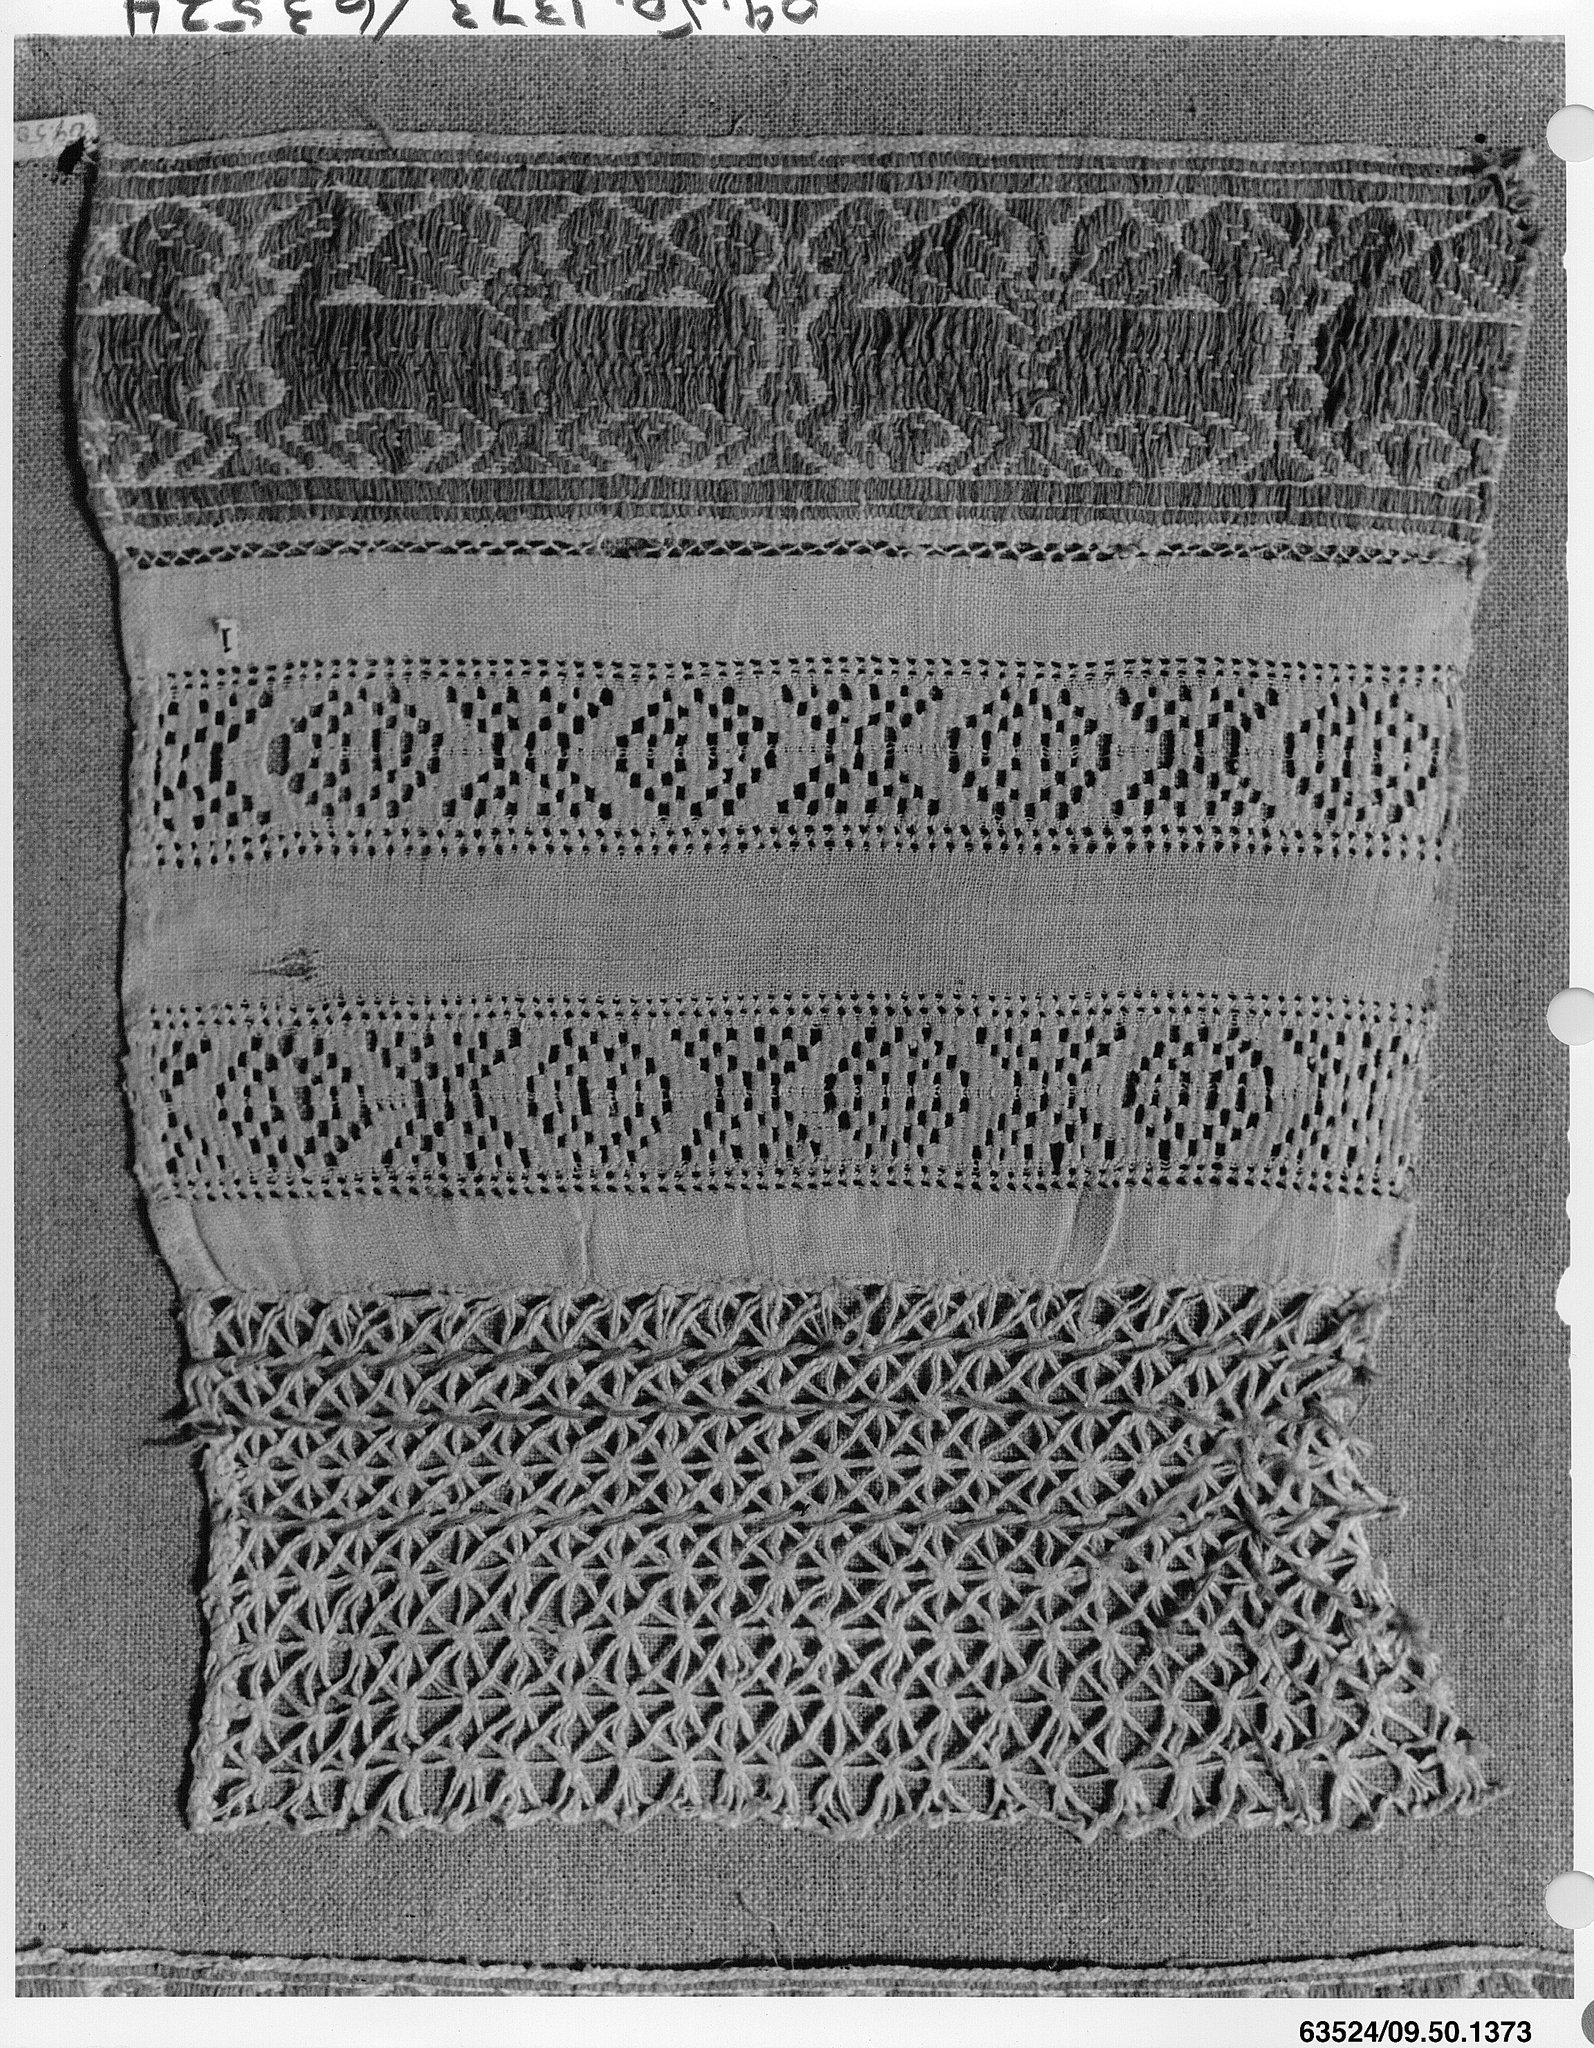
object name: band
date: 1701-1900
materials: cotton, linen